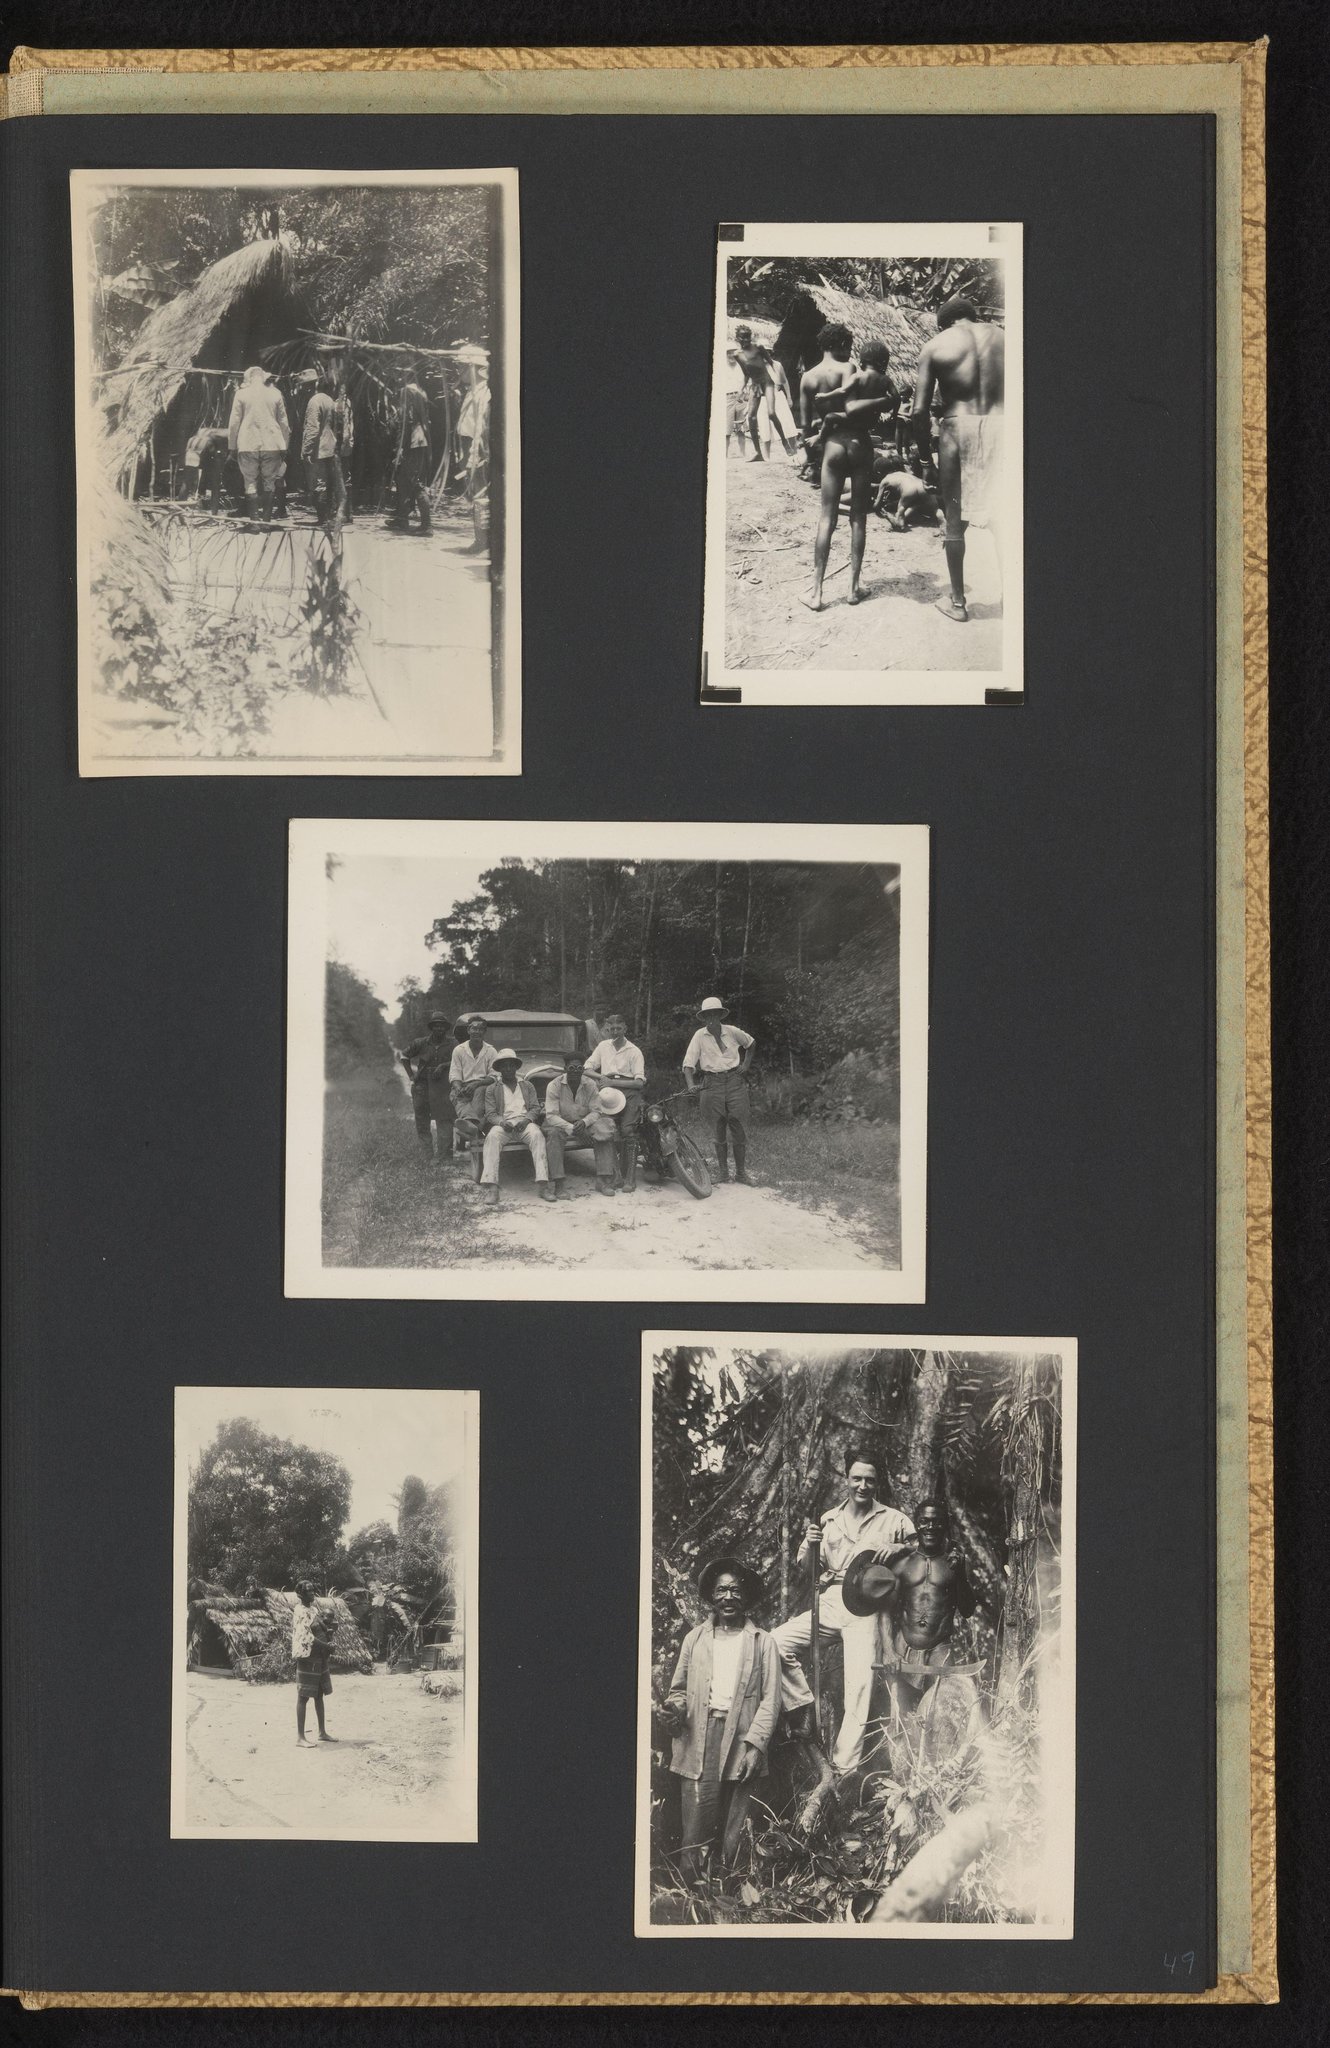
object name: album leaf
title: Bezoek aan een dorp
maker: Anonymous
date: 1927-1931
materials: paper, photographic support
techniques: gelatin silver print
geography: suriname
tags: village, suriname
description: Albumblad met vijf foto's van een bezoek gebracht door een groep Europeanen aan een Surinaams dorp. Onderdeel van het album van de familie Guilonard over de bauxietwinning in Moengo en Albina in Suriname in de jaren 1929-1930.